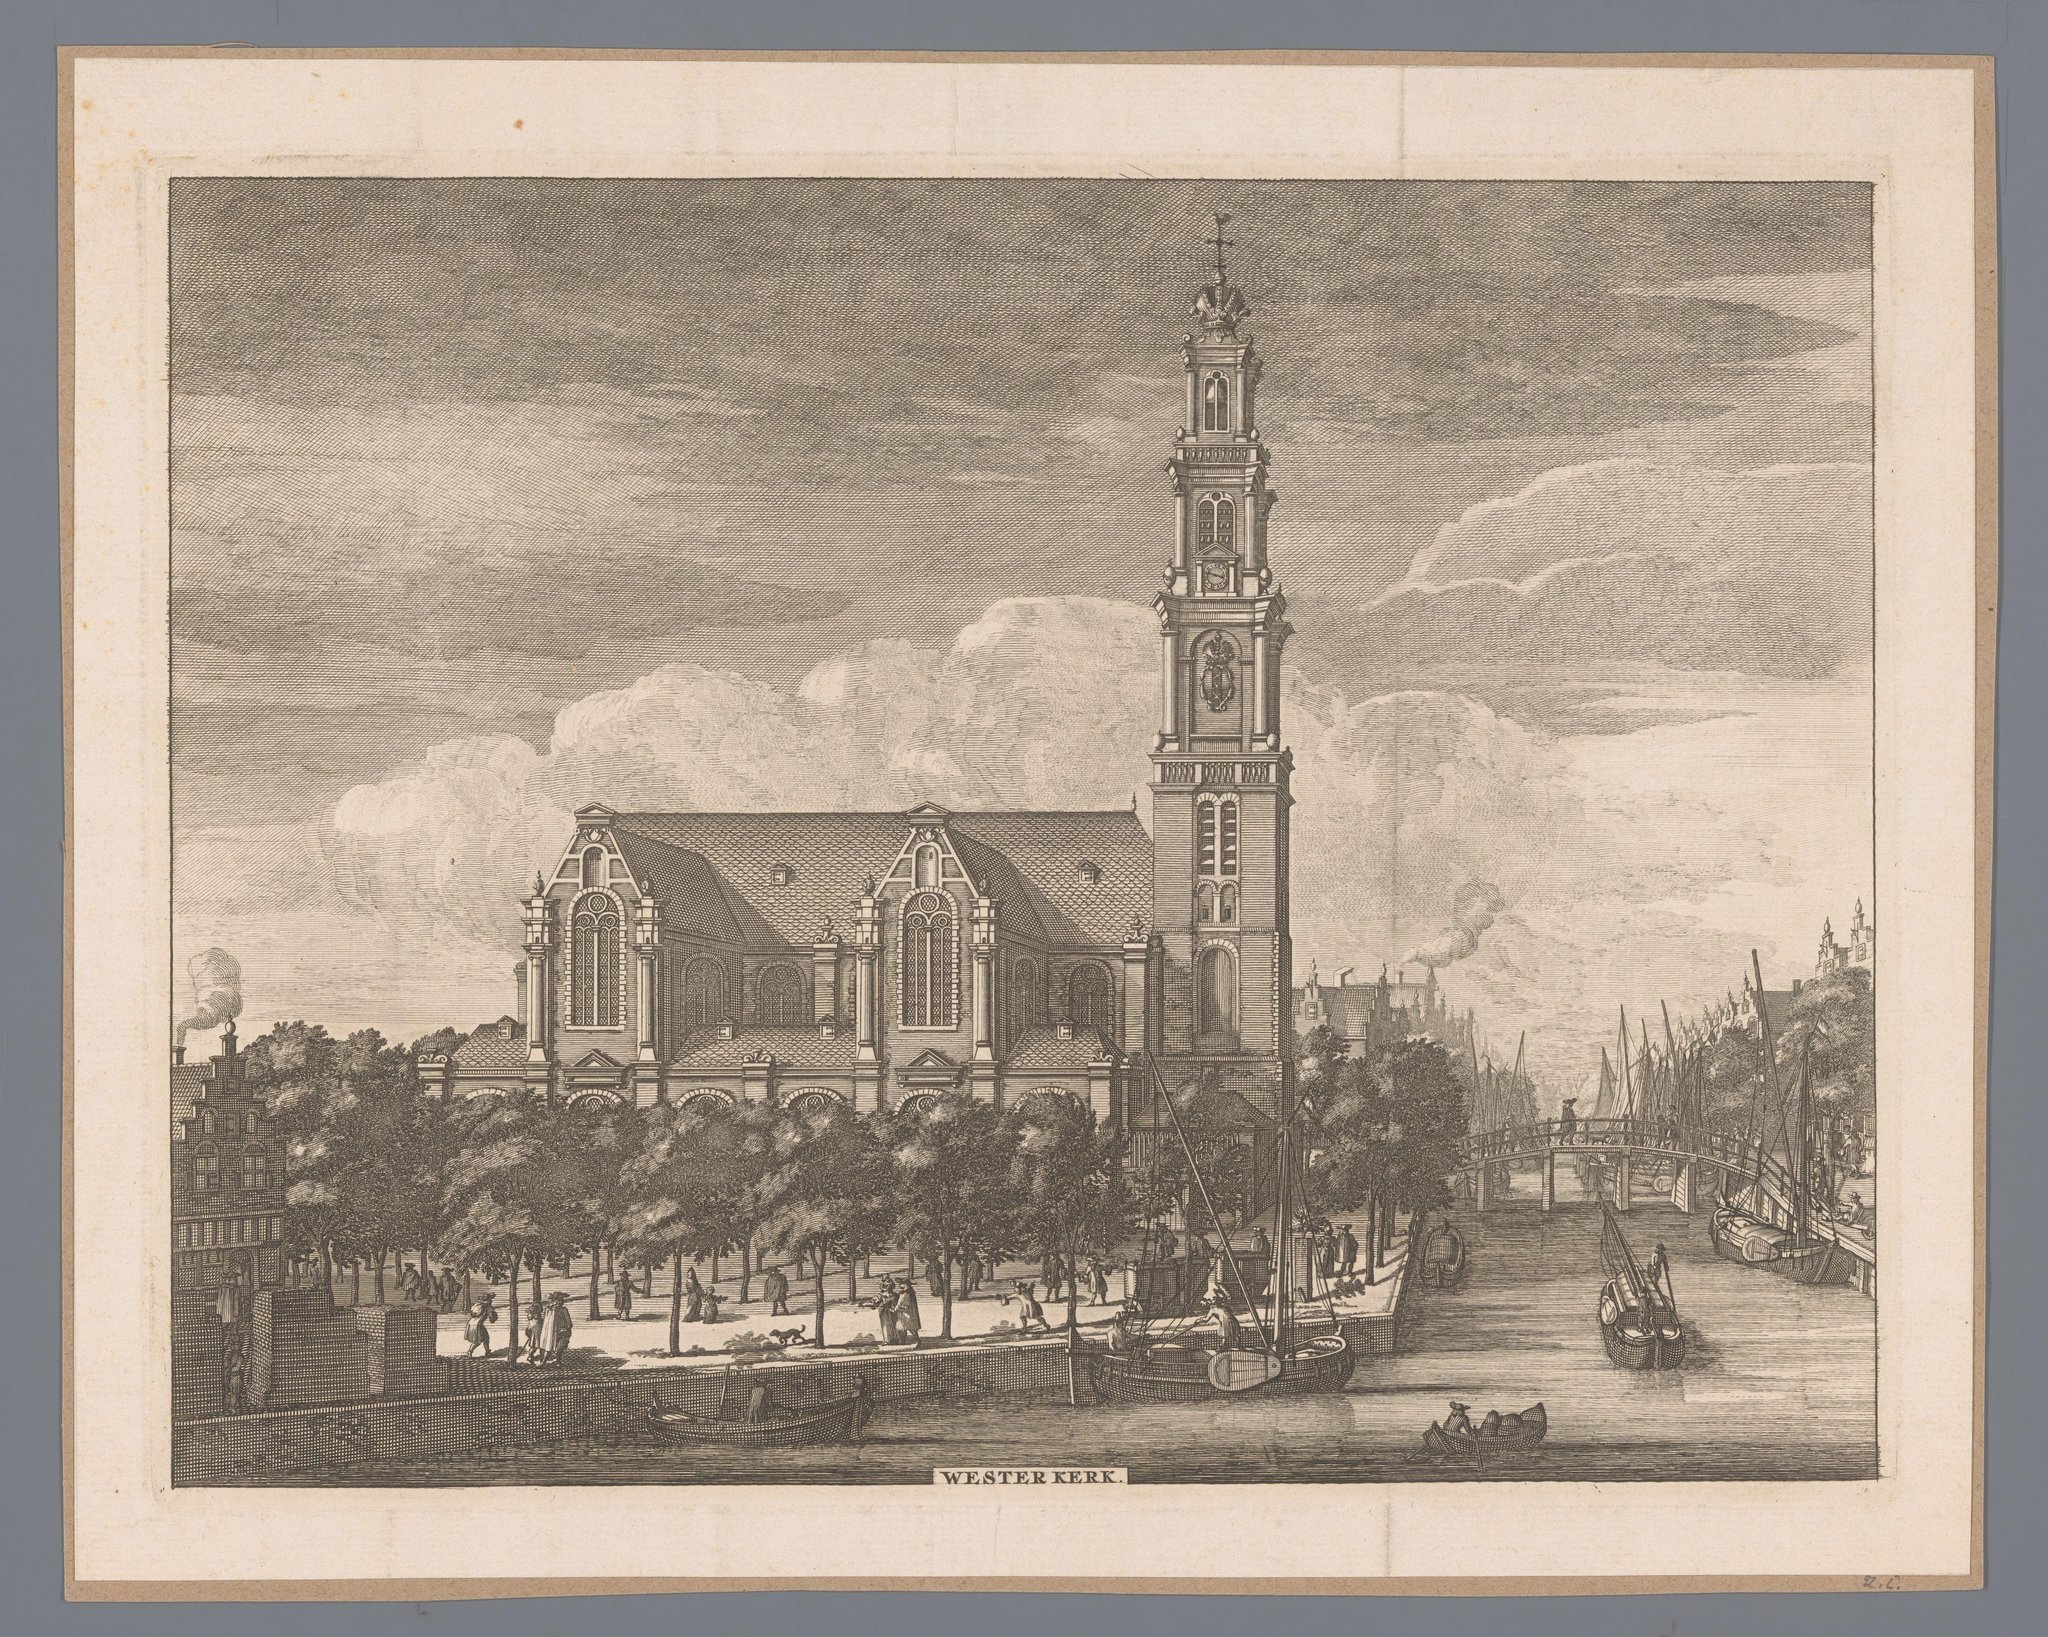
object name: print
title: Wester Kerk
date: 1726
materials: paper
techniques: engraving, etching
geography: amsterdam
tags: bridge in city across river, canal, etc. (+ city(-scape) with figures, staffage), church (exterior)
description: Prent uit: Commelin, Caspar. Beschryvinge van Amsterdam, zynde een naukeurige verhandelinge van desselfs eerste oorspronk uyt (…). Amsterdam: Andries van Damme et al., 1726. Eerdere staat gebruikt in: Commelin, Caspar. Beschryvinge van Amsterdam, desselfs eerste oorspronk uyt den Huyse (…). Amsterdam: Abraham Wolfgang et al., 1693. En in: Commelin, Caspar. Beschryvinge van Amsterdam, zynde een naukeurige verhandelinge van desselfs eerste oorspronk uyt (…). Amsterdam: weduwe Aart Dircksz Oossaan, 1694.